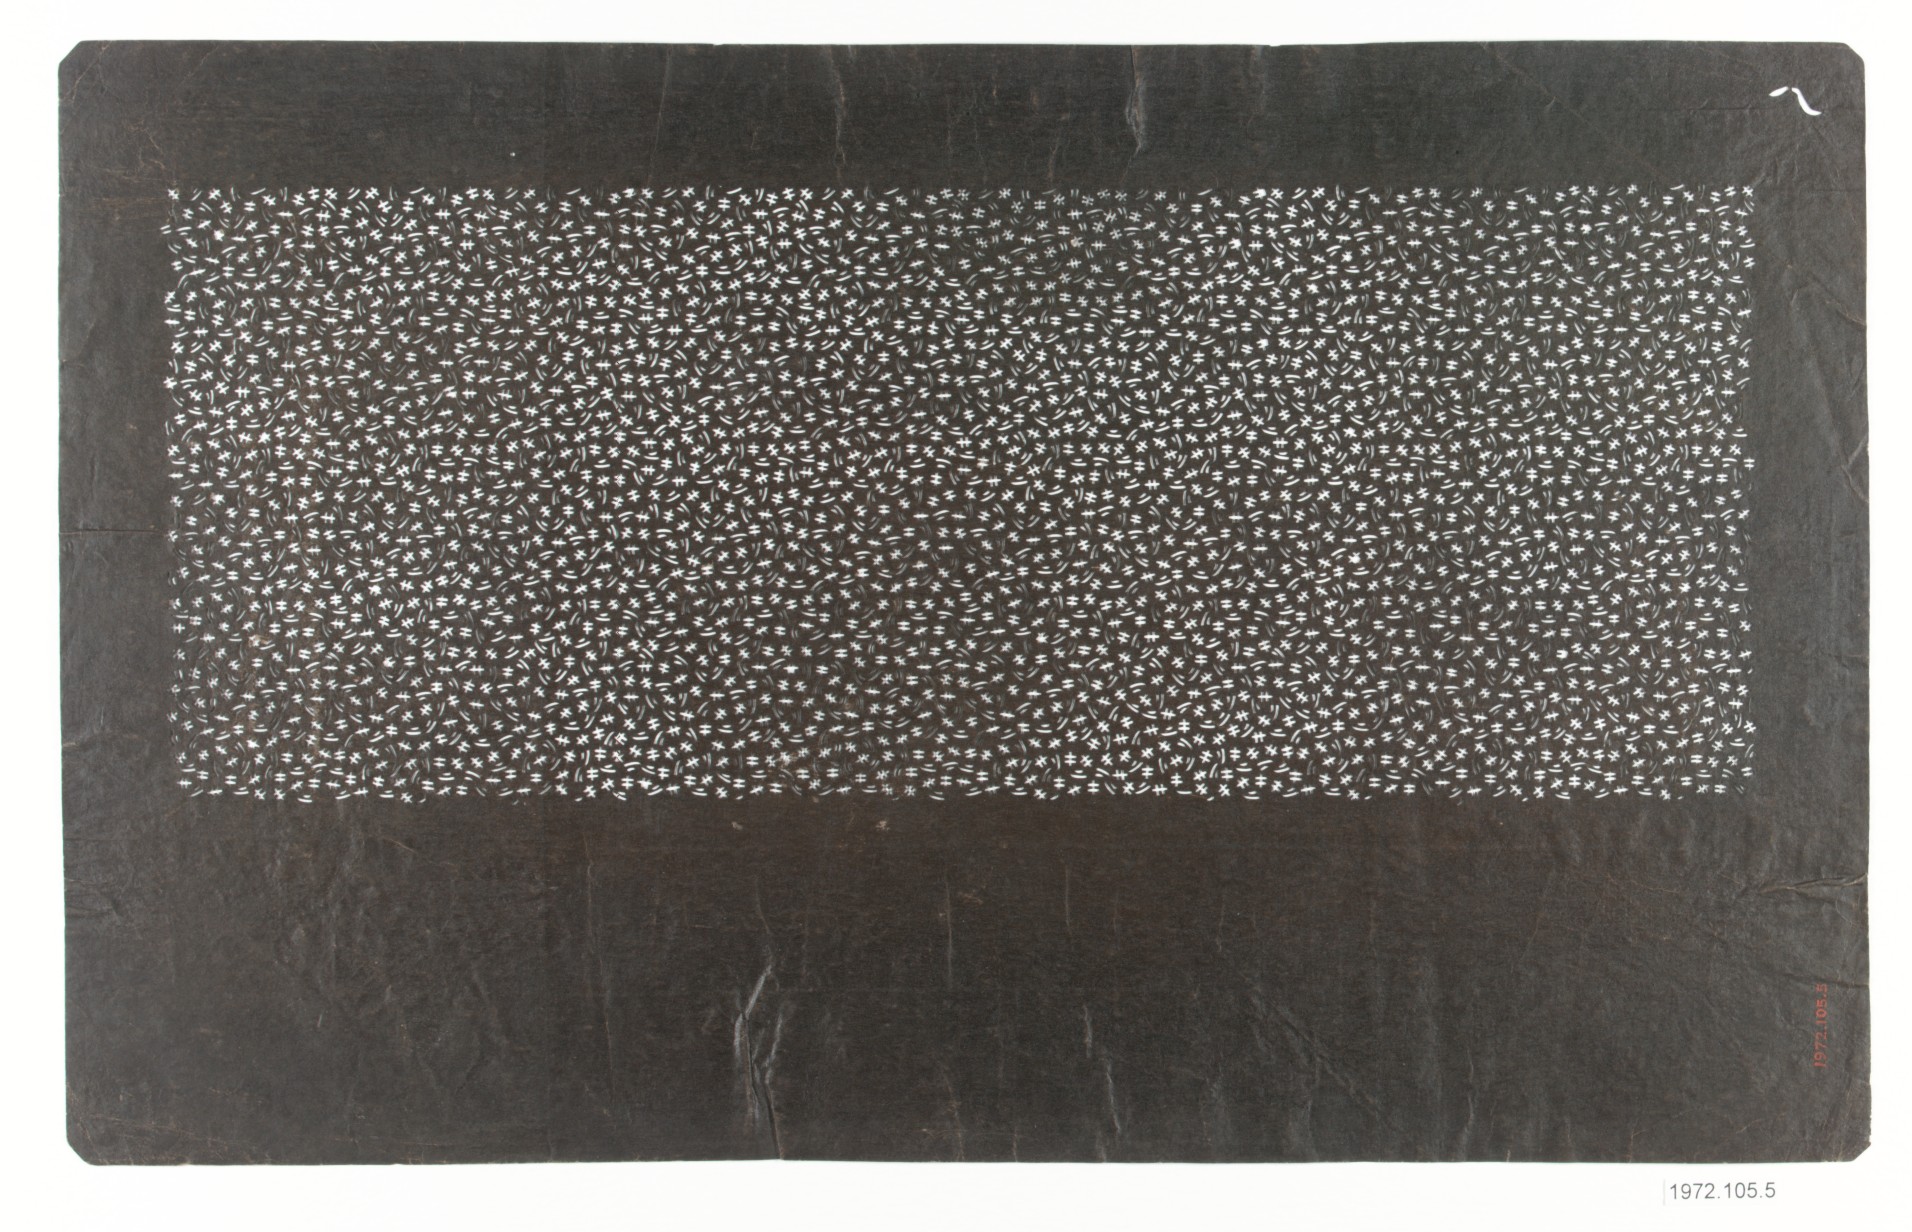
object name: stencil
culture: japanese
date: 1701-1900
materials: paper